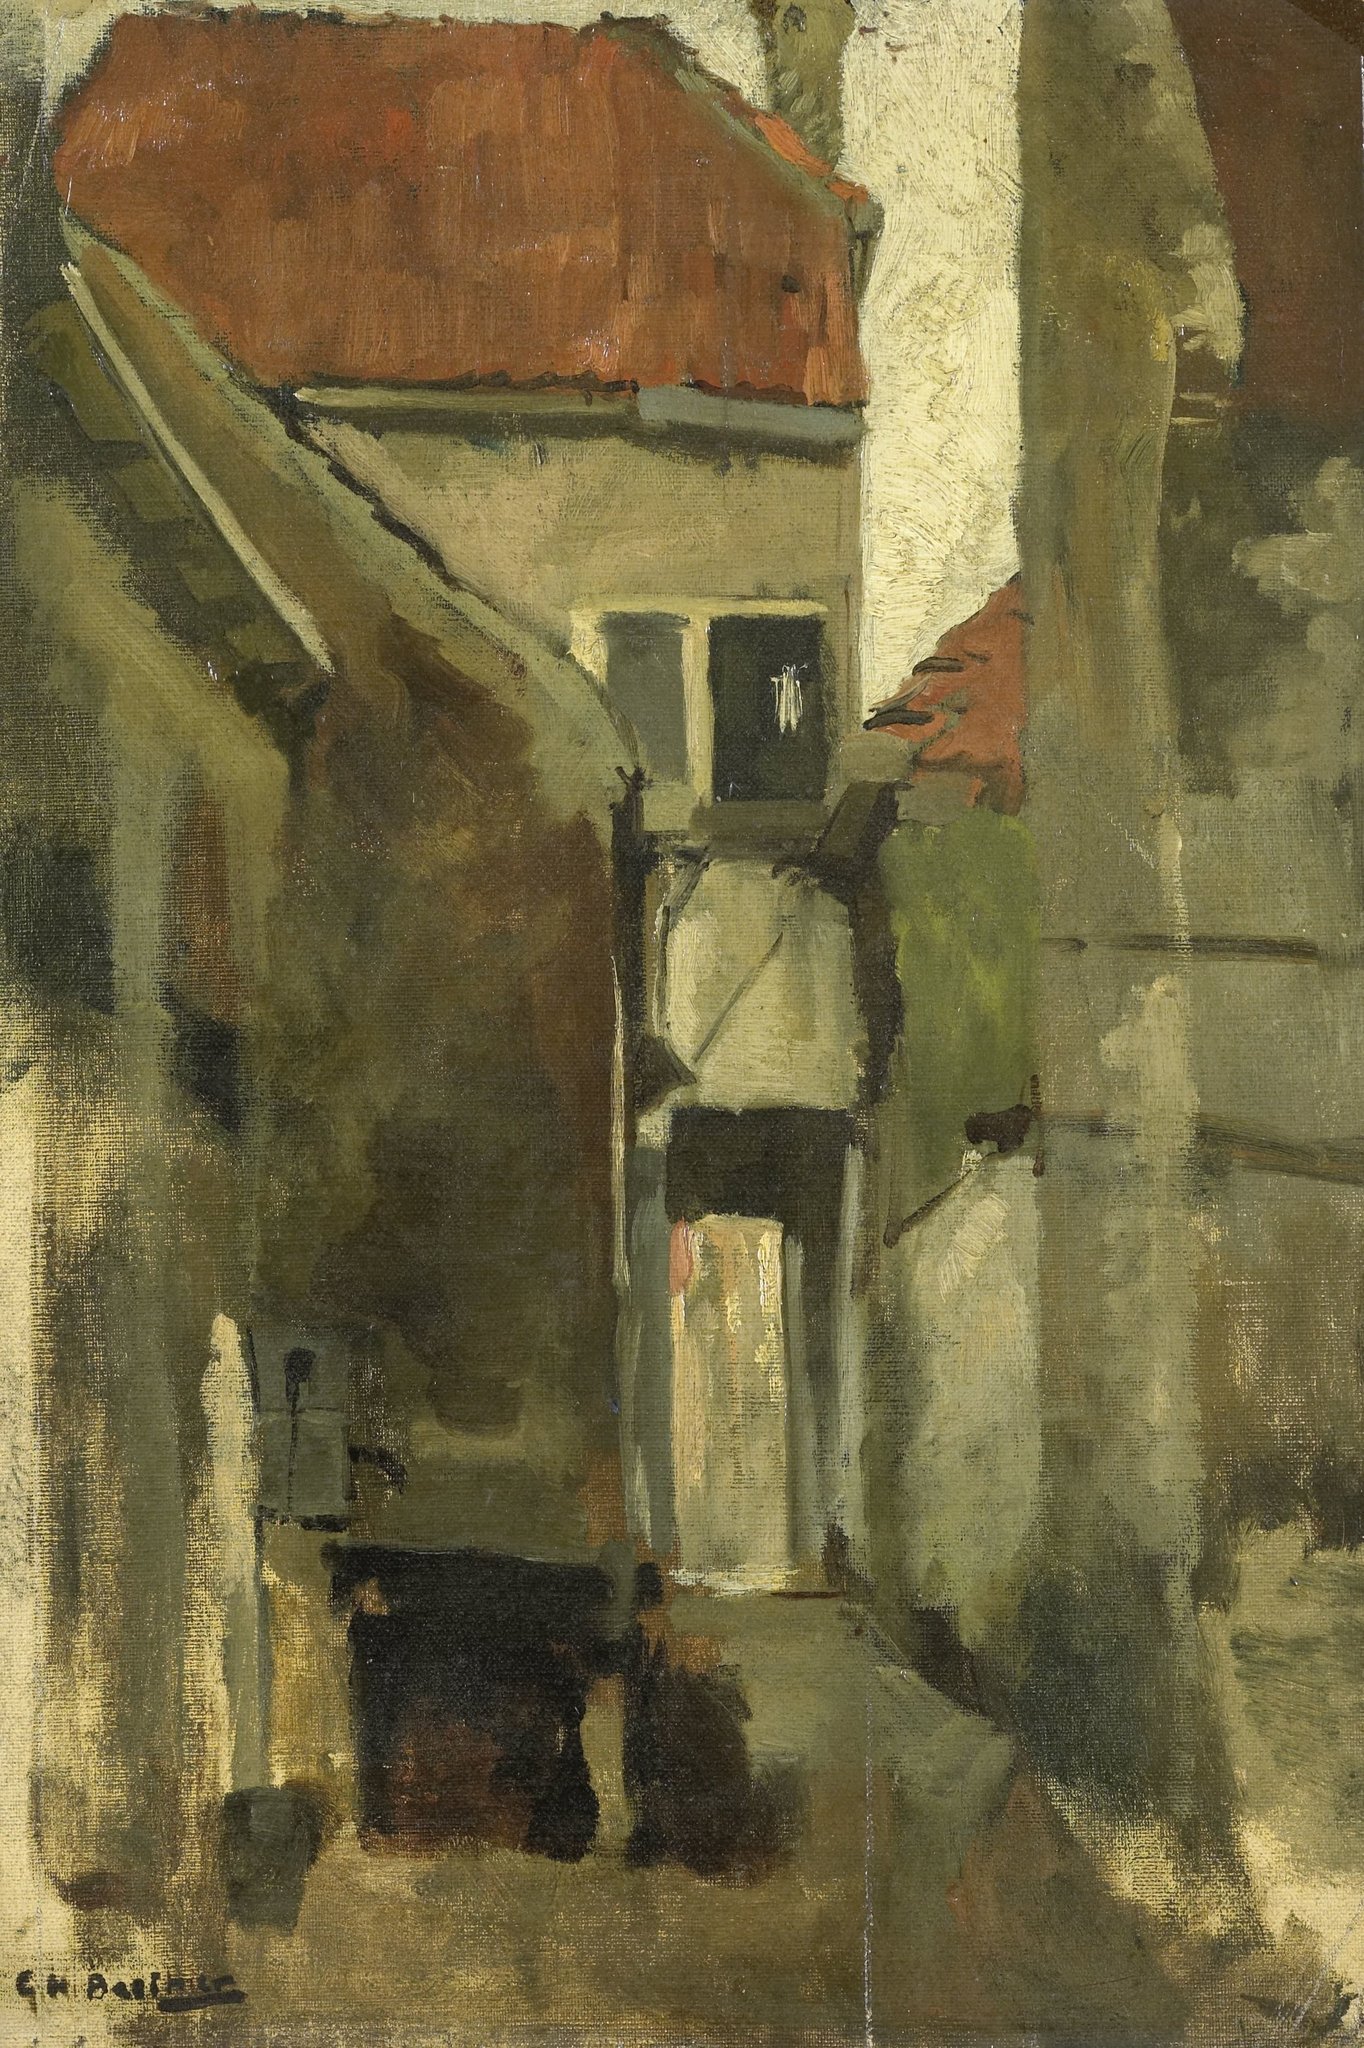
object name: painting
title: Neighborhood Street in Rijswijk near The Hague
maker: george hendrik breitner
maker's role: draughtsman, painter, print maker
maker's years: 1857-1923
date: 1880-1923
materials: canvas, oil, panel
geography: netherlands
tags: public road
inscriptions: signature: ‘G.H. Breitner’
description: Buurtje in Rijswijk. Gezicht door een straatje tussen huizen.